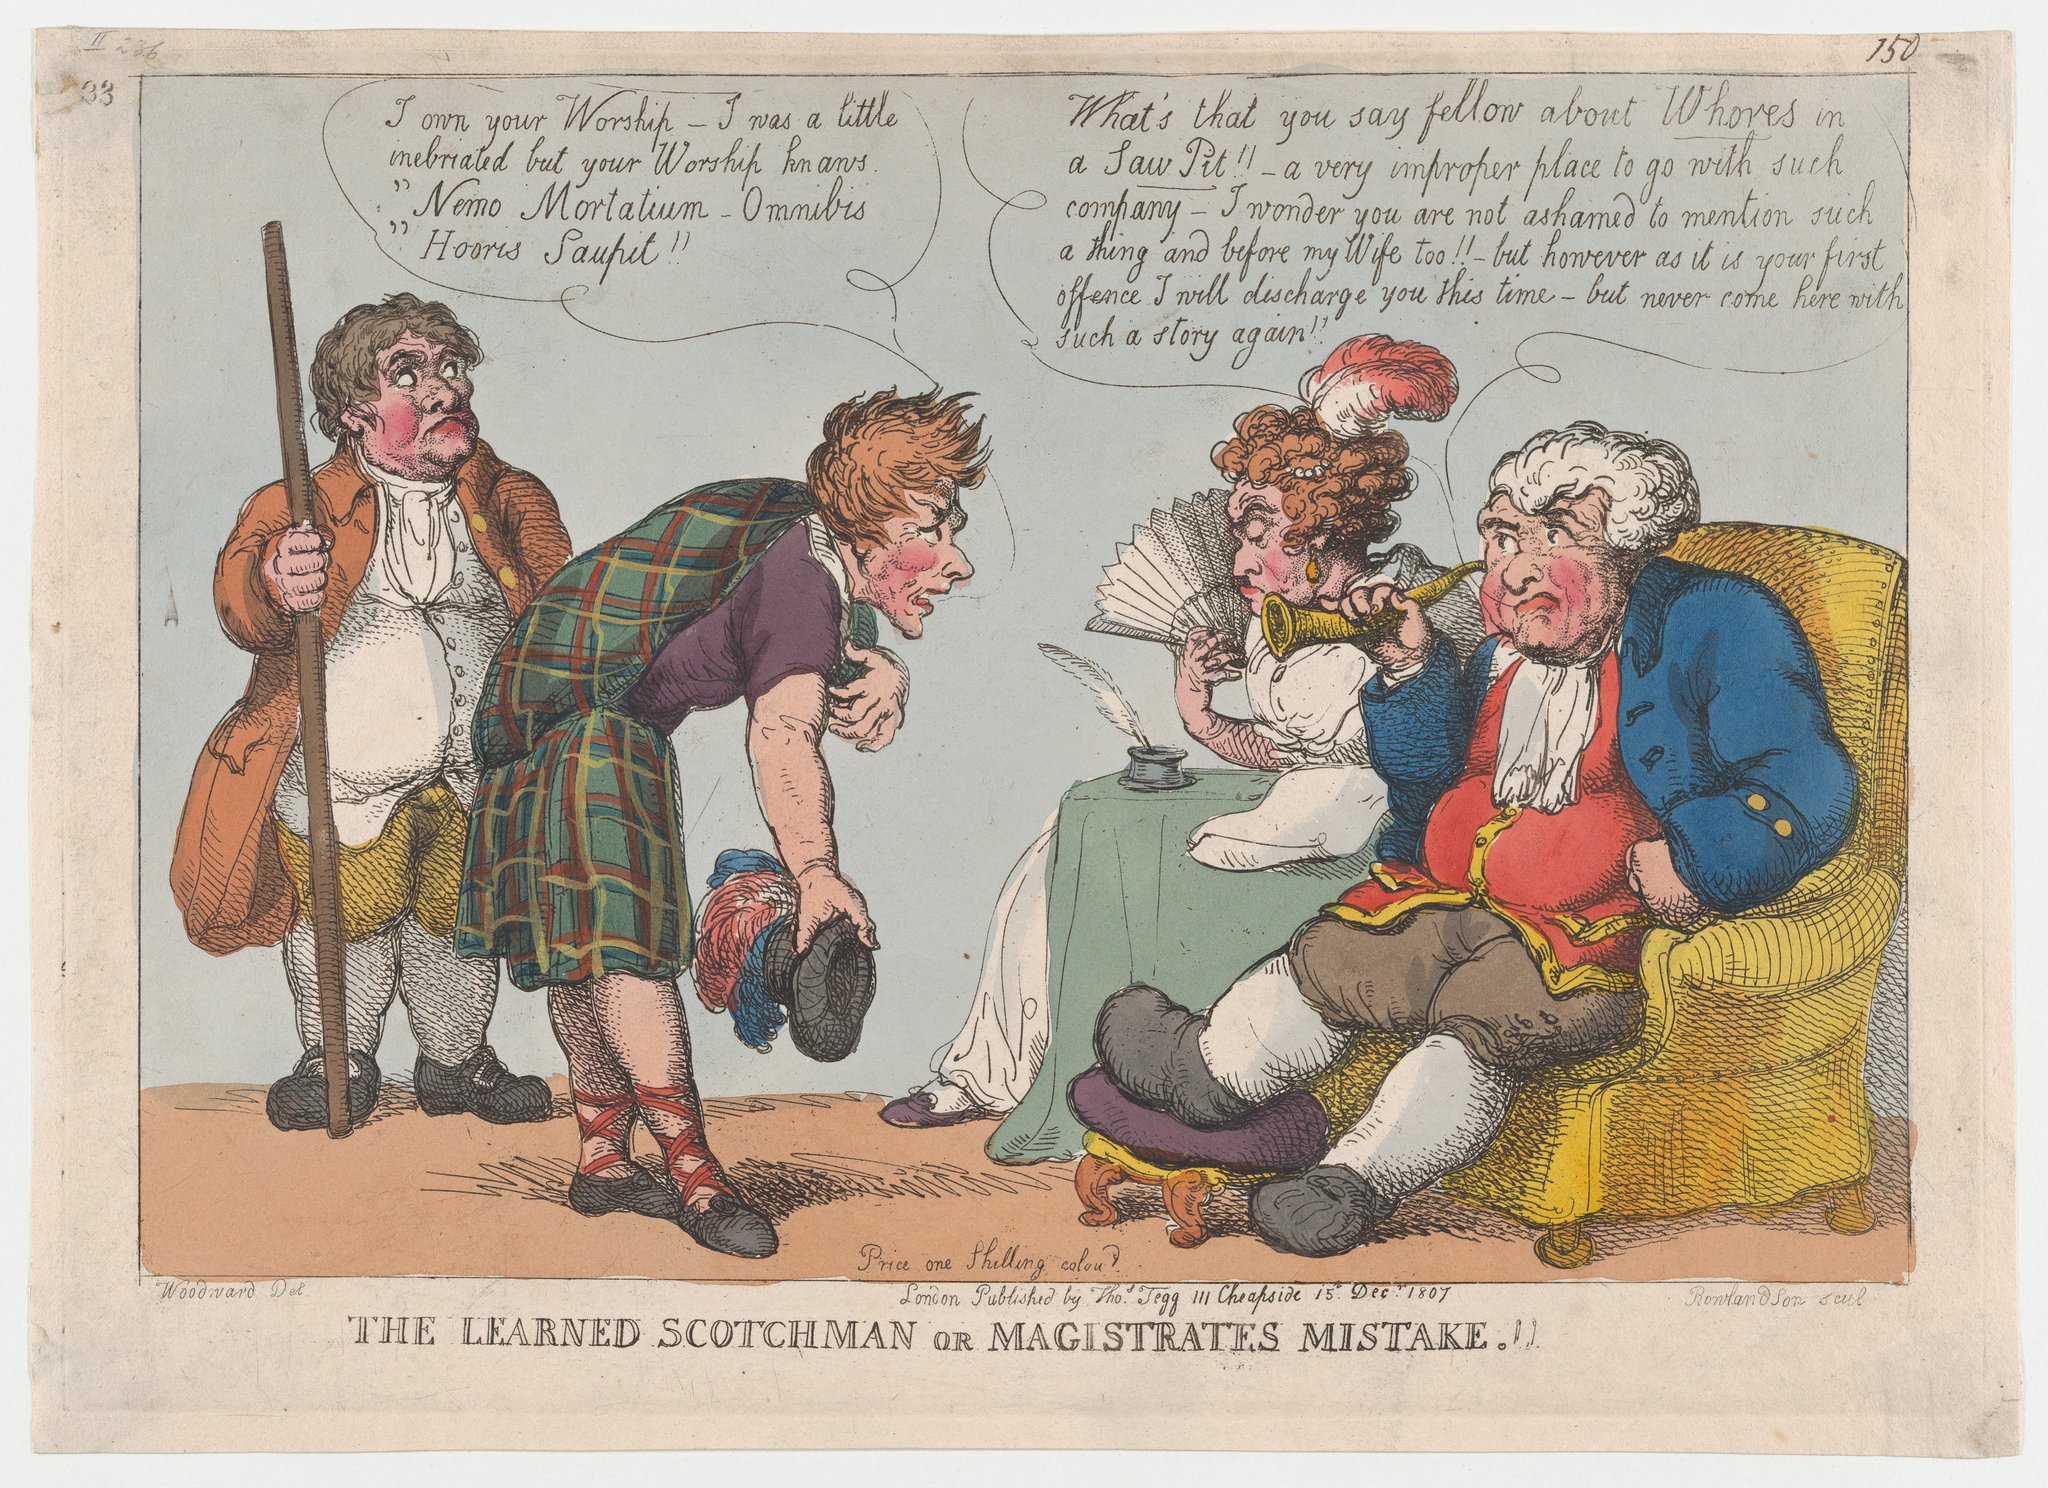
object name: print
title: The Learned Scotchman, or Magistrates Mistake!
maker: thomas rowlandson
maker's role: artist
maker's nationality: british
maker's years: 1757-1827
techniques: etching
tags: satire,men,women